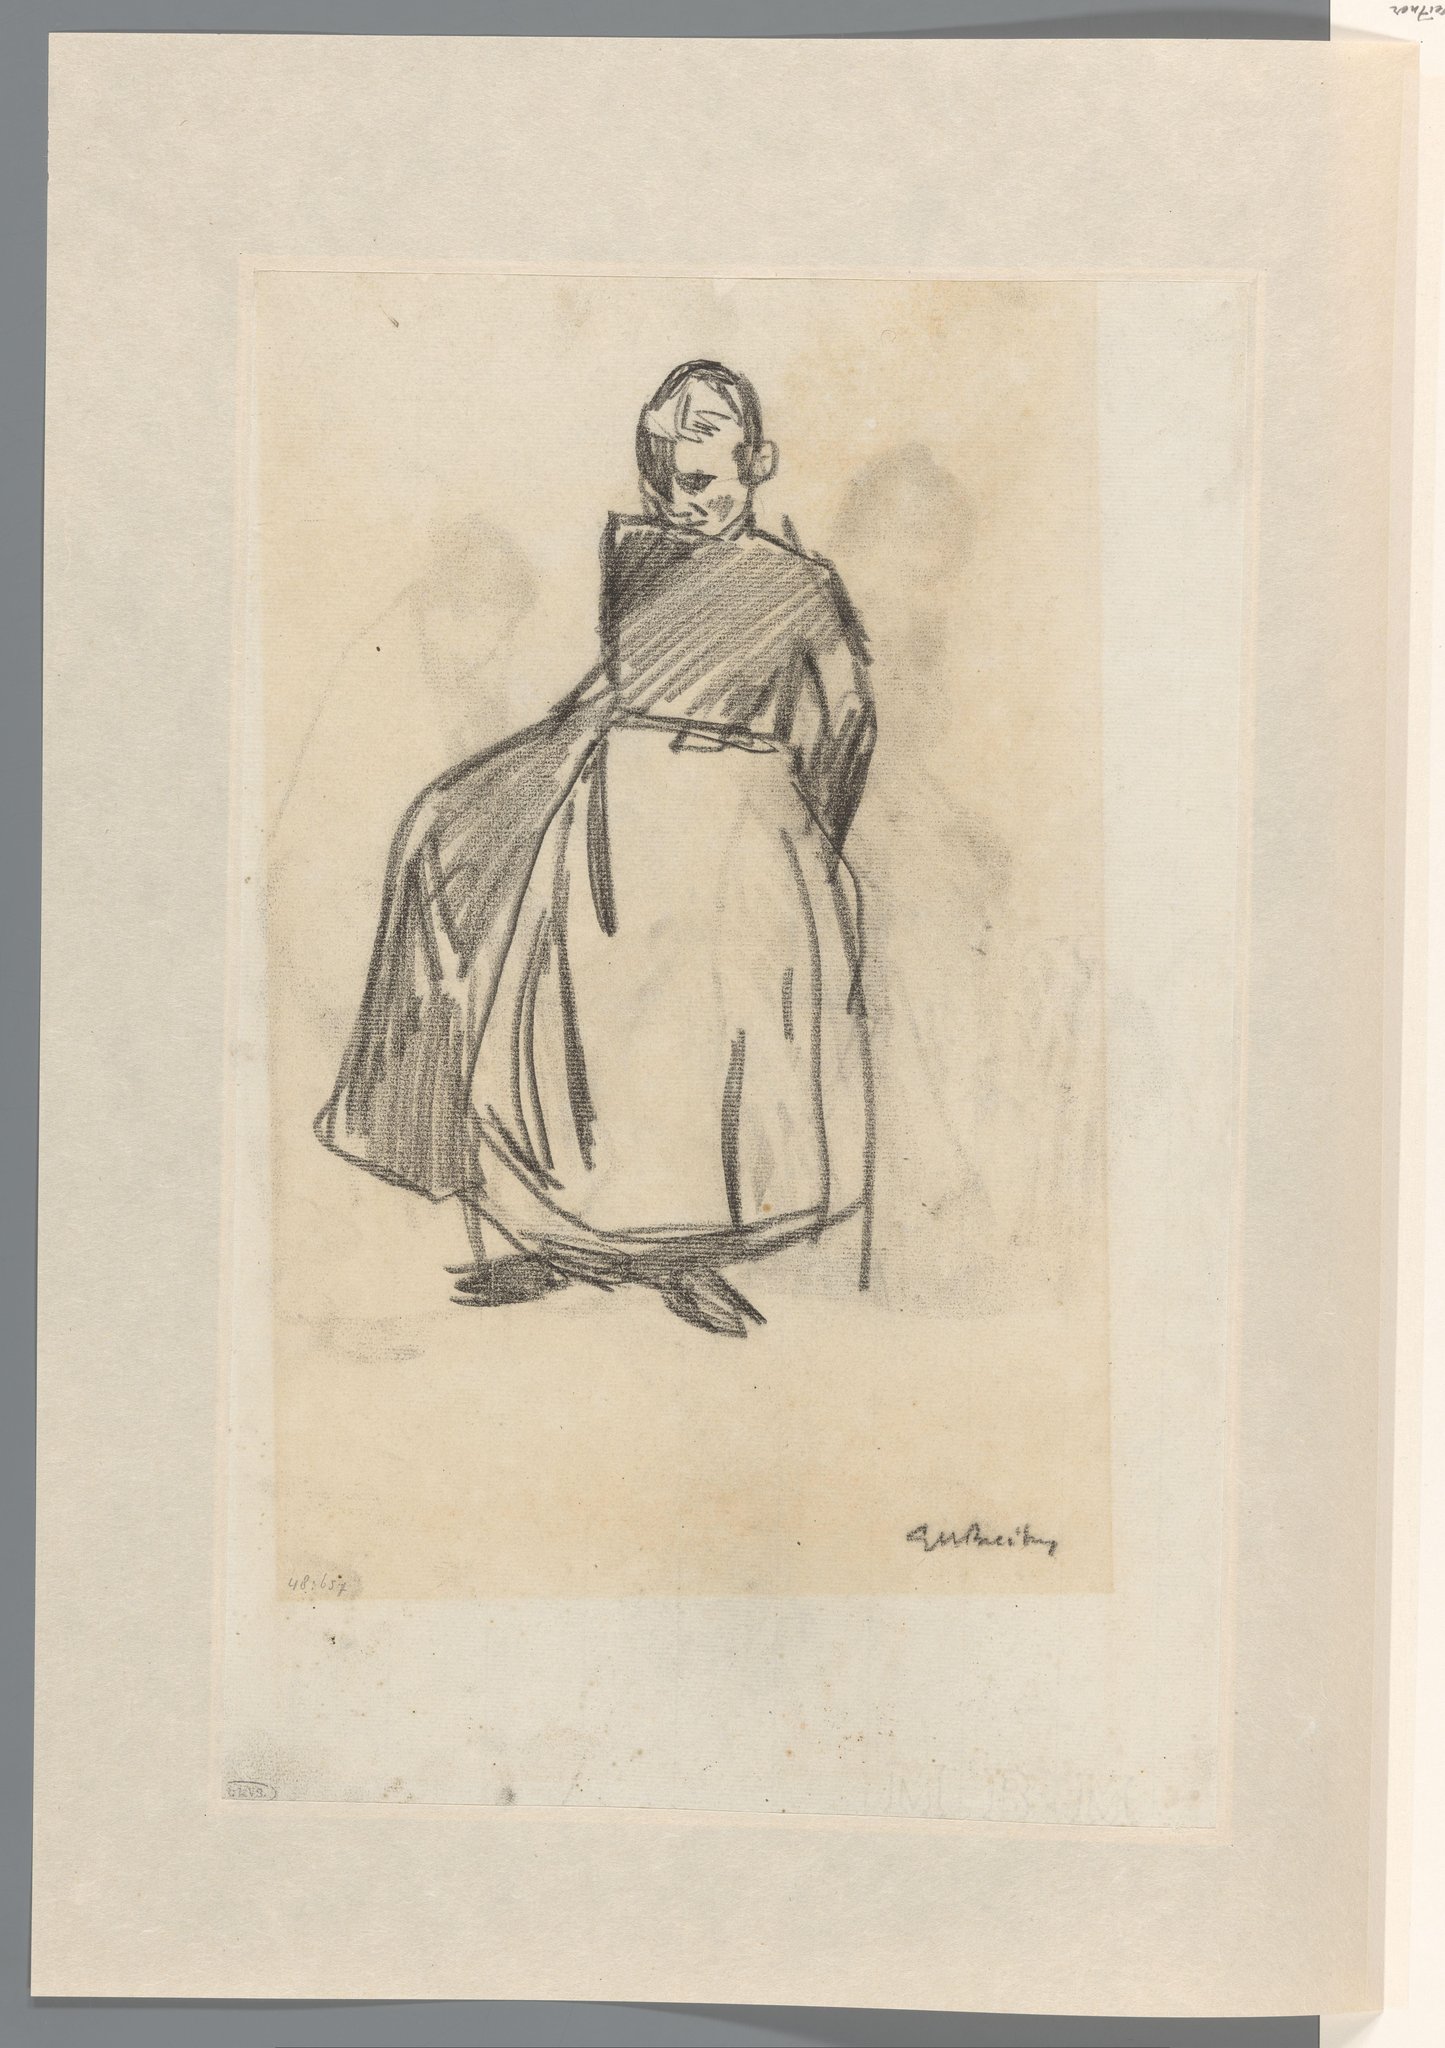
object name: drawing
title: Zittende meid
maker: george hendrik breitner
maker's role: draughtsman, painter, print maker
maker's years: 1857-1923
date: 1867-1923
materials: chalk, paper